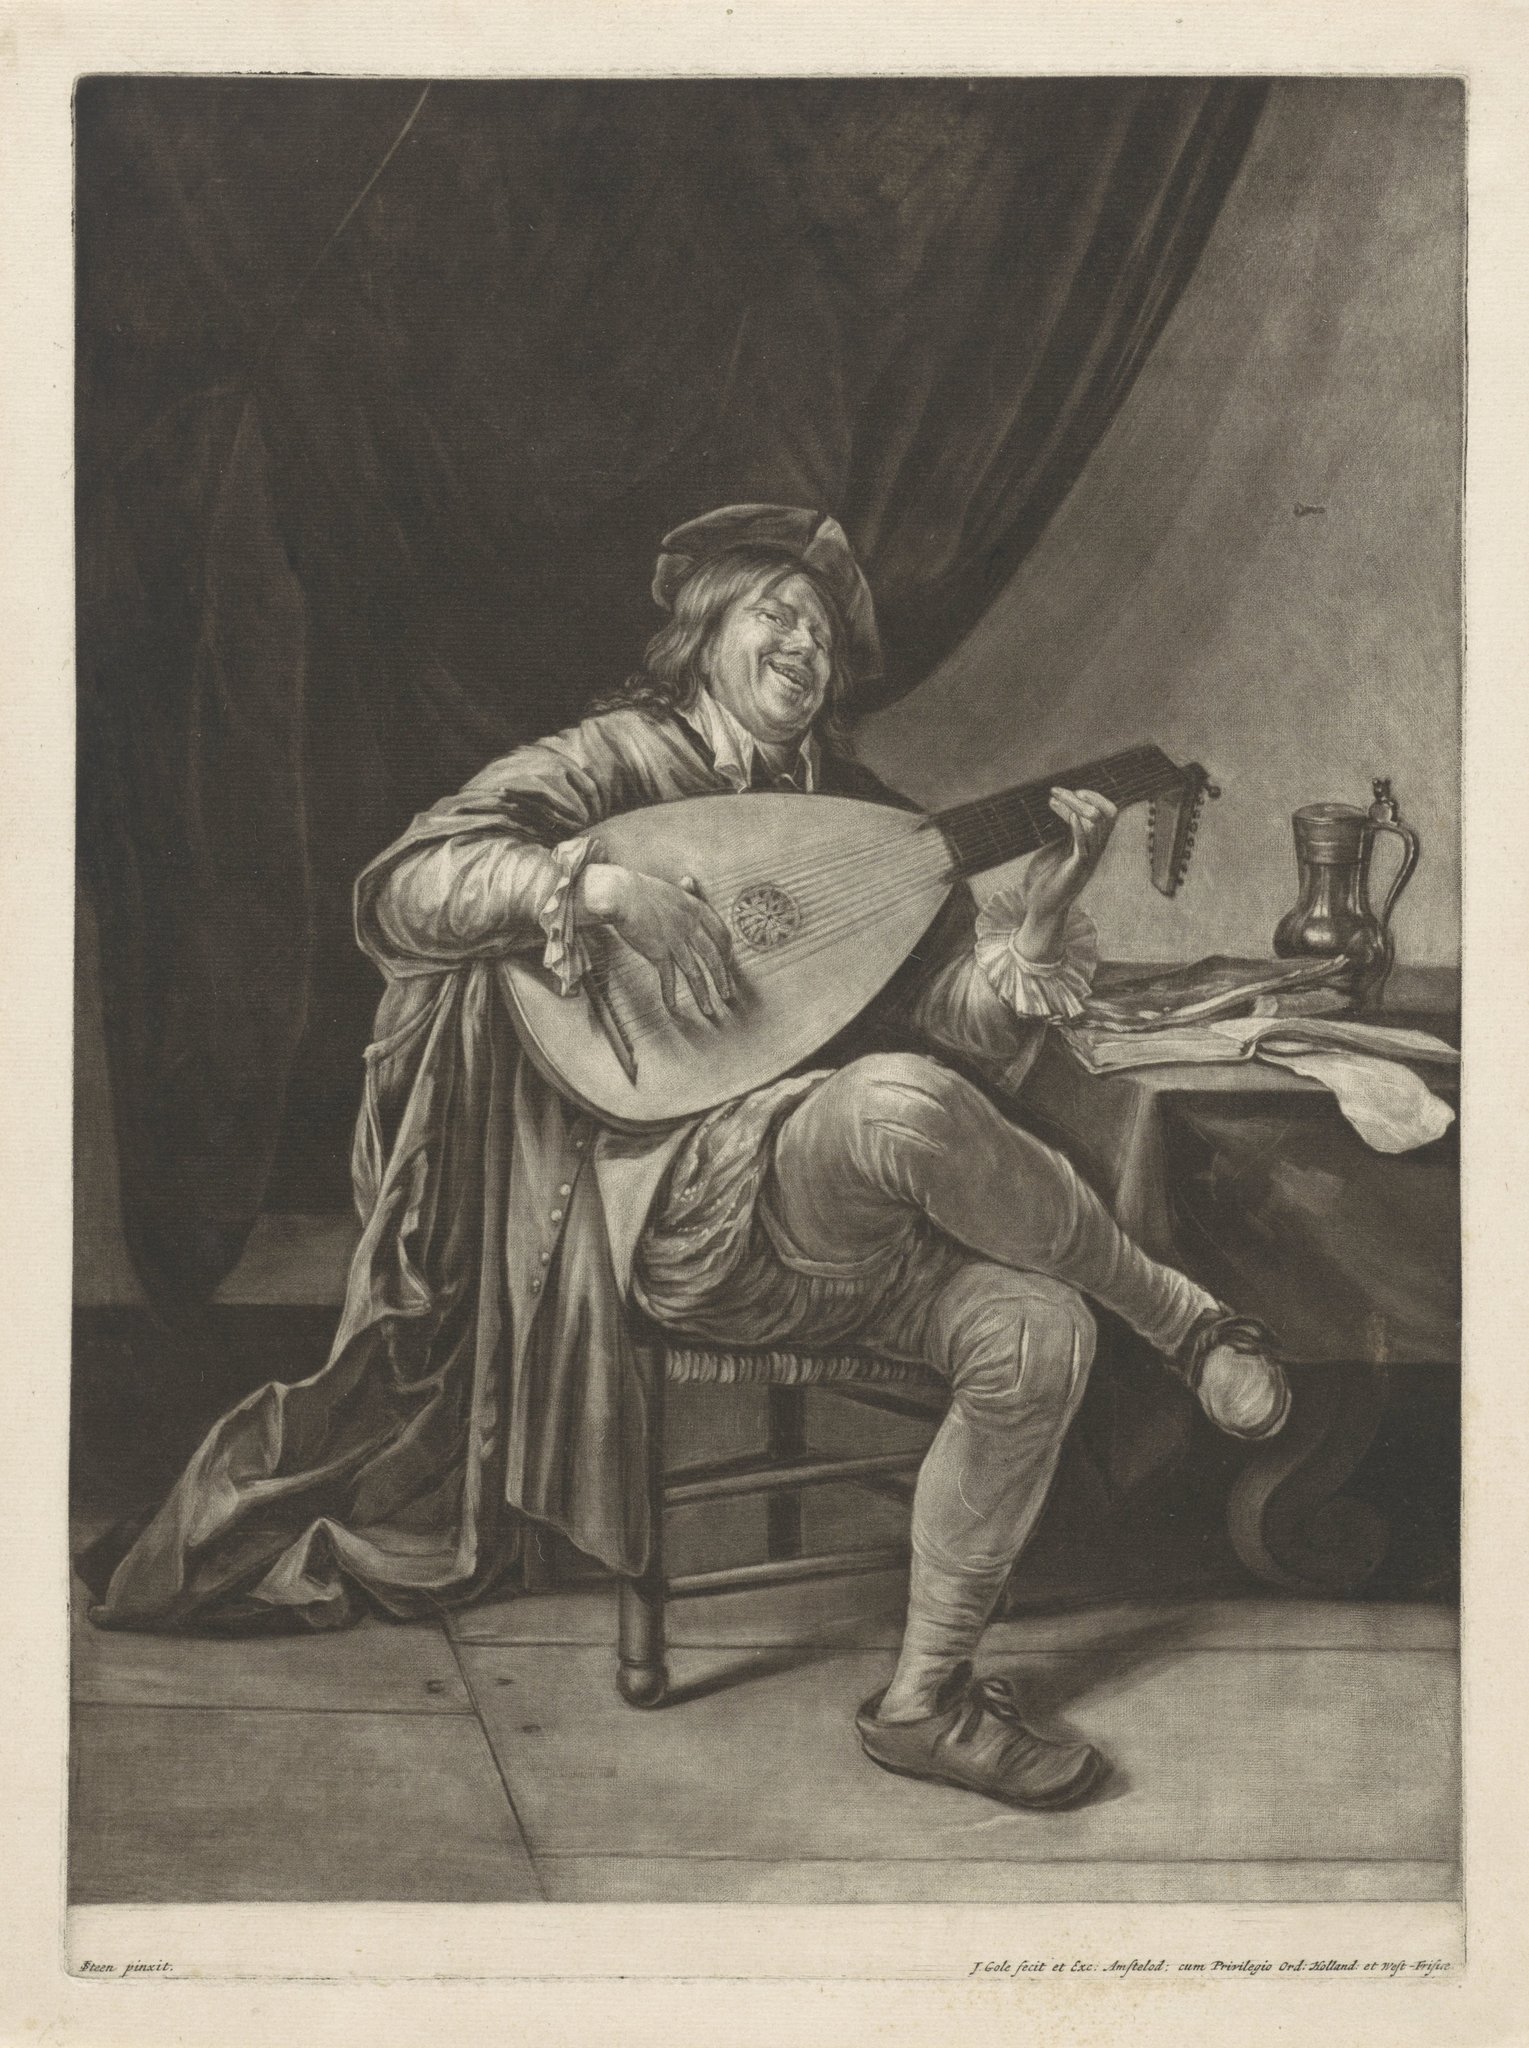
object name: print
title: Zelfportret van Jan Steen als luitspeler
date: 1670-1724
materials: paper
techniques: engraving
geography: amsterdam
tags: leiden, painter, print maker, jan havicksz. steen, portrait, self-portrait of painter, lute, and special forms of lute, e.g.: theorbo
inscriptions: collector's mark: Lugt 240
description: Zelfportret van de schilder Jan Steen. Hij bespeelt een luit en lacht naar de toeschouwer. Op de tafel naast hem een opengeslagen boekje, enkele papieren en een kan.